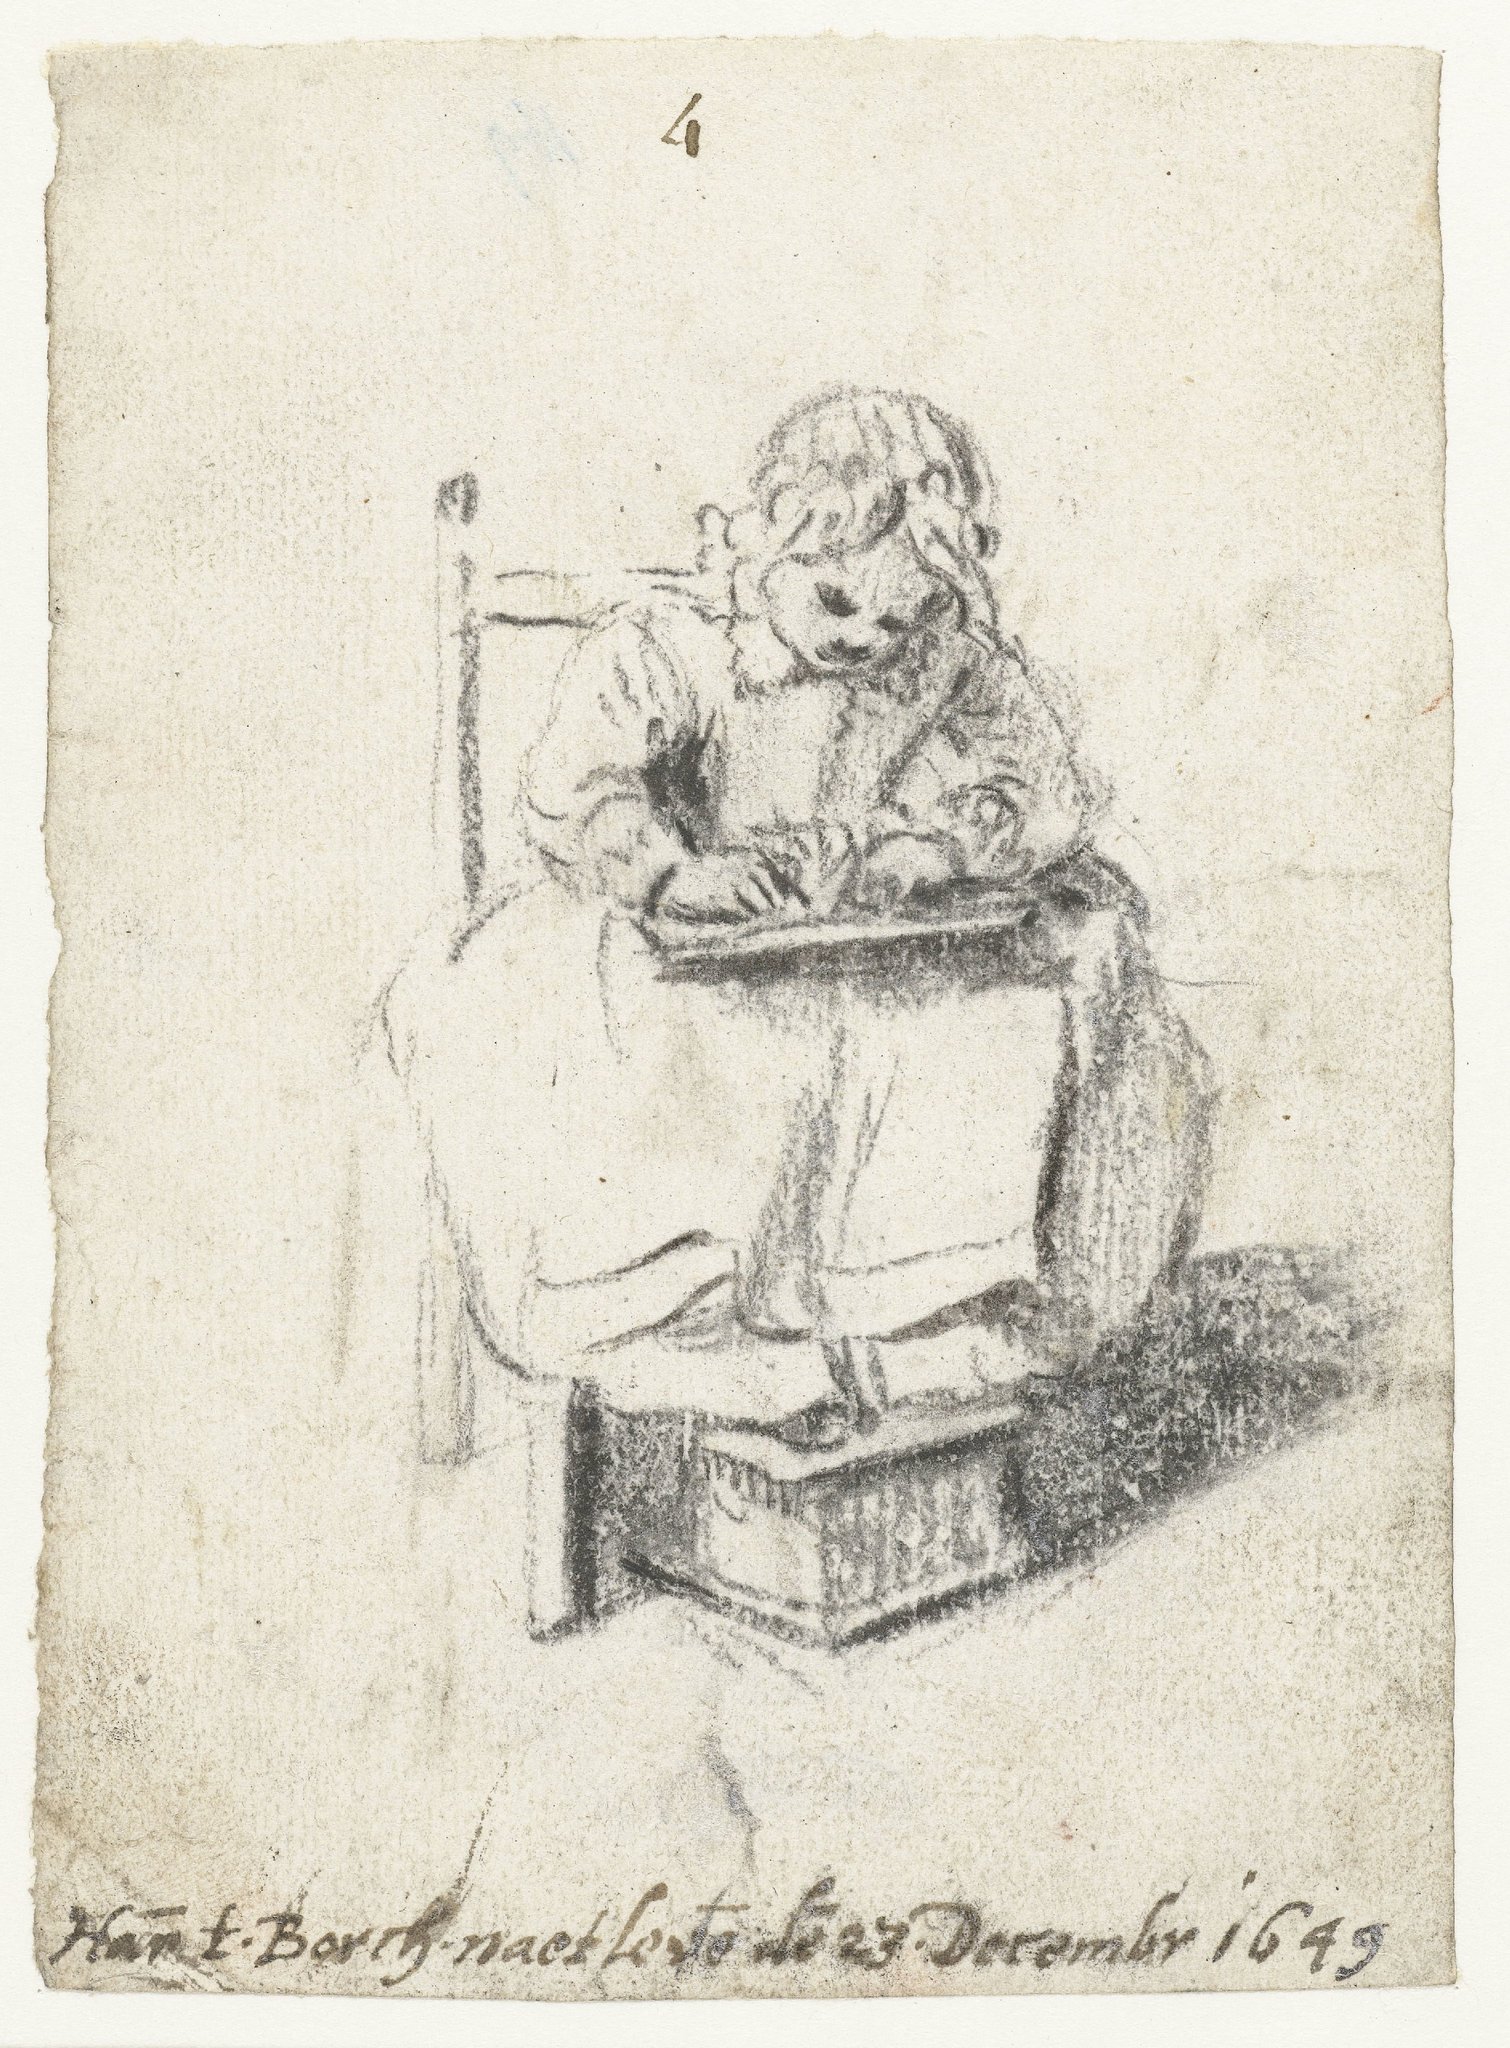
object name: drawing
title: Child Drawing or Writing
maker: harmen ter borch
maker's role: draughtsman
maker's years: 1638-1677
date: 1649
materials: chalk, paper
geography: zwolle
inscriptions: annotation: ‘Har[men] t.Borch. naet leve[n] de[n] 23.Decembr 1649’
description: The children in the Ter Borch family learned how to draw at a young age at home. Little Harmen too had a flair for this. He made this drawing ‘naet leve’ (from life) on 23 December 1649 – he was then a mere eleven years old. The sitter is probably his younger brother Moses, who rests his feet on a foot stove while writing or drawing.